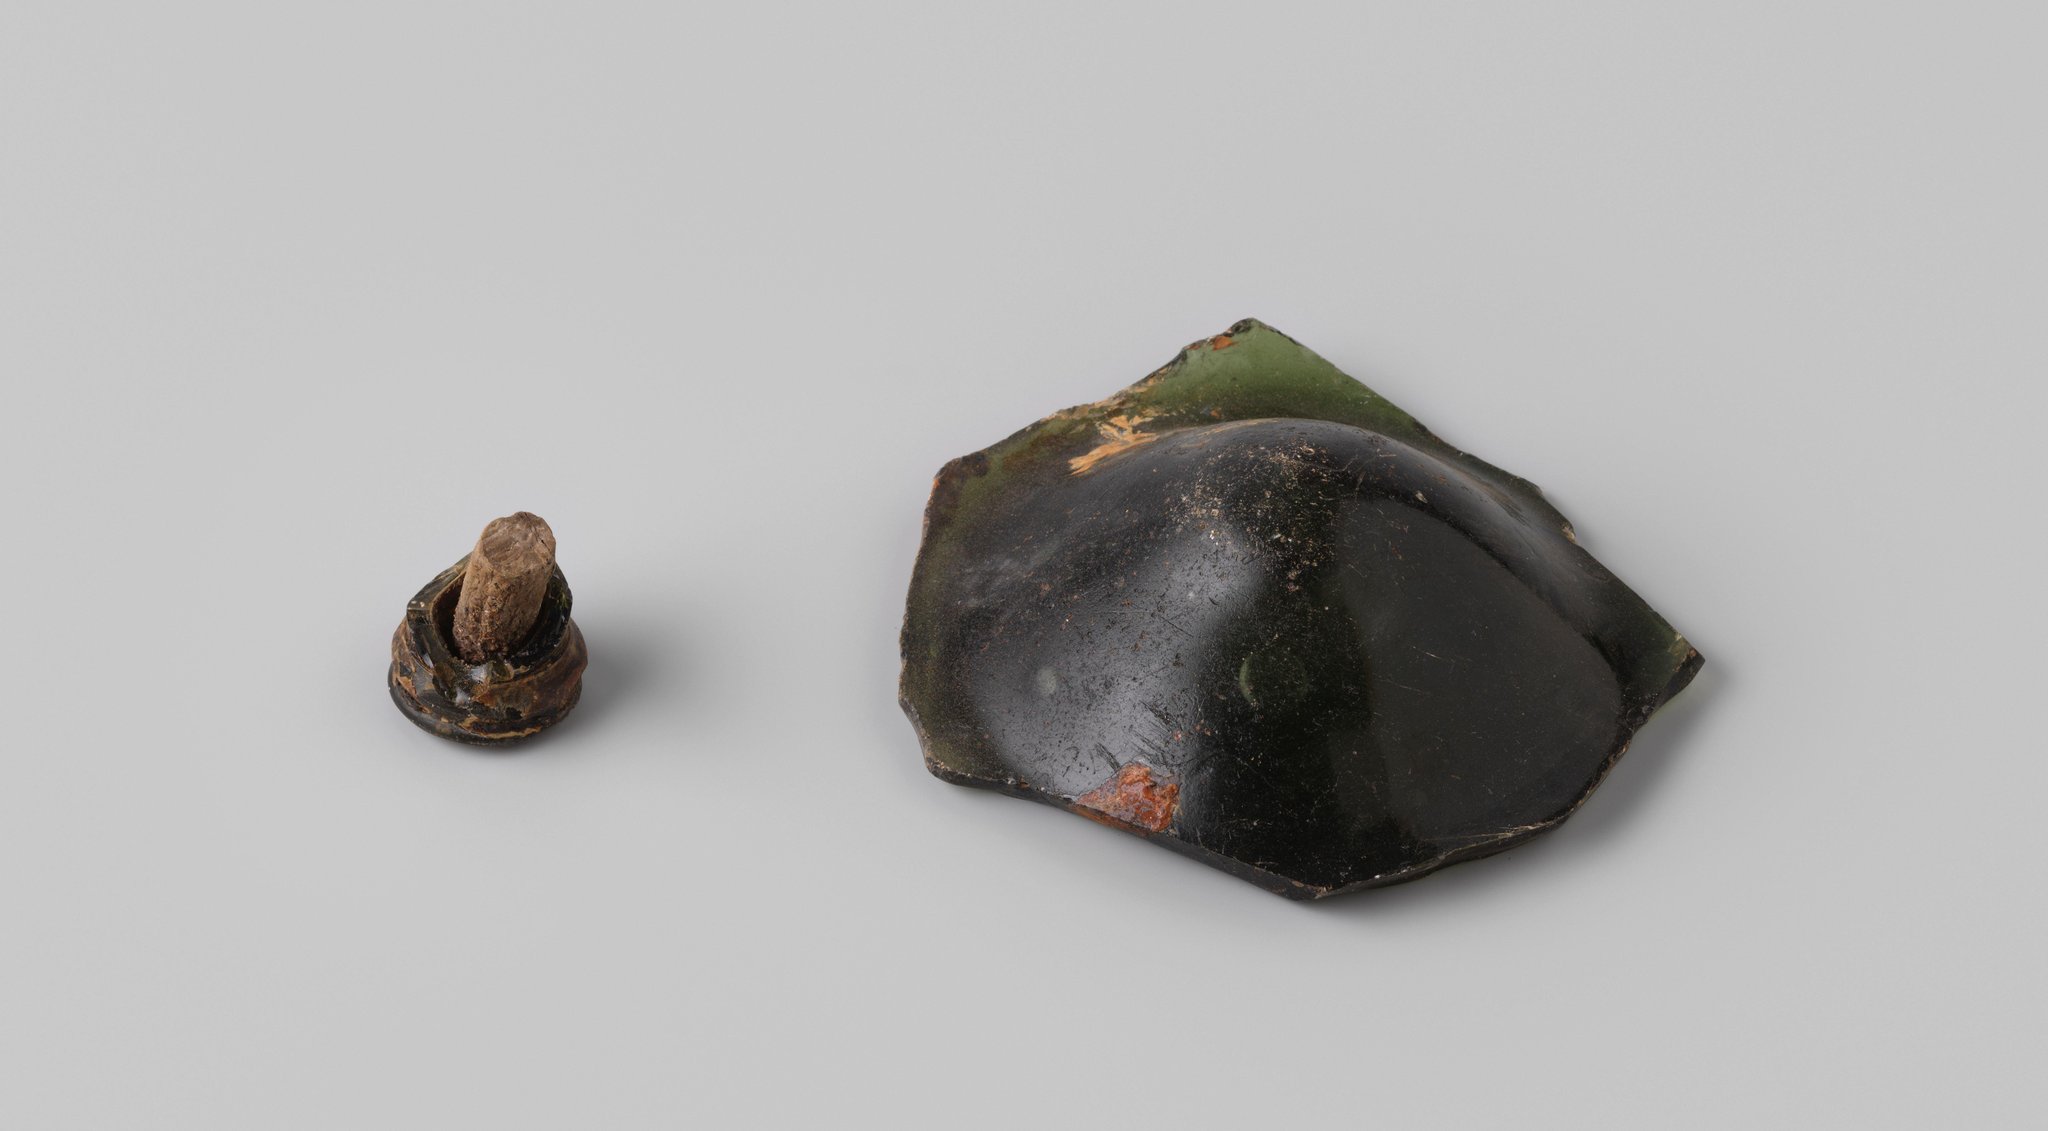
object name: neck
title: Hals met kurk en bodemfragment van een wijnfles uit het wrak van de Oost-Indiëvaarder Hollandia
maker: Anonymous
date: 1700-1743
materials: cork, glass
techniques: green glass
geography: netherlands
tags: verenigde oostindische compagnie, hollandia (schip), annet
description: Wine bottle, continental production, neck, onion-shaped bottle or bottle with vertical side; (1) fragm (2h), broad f-string rim, cork level with mouth